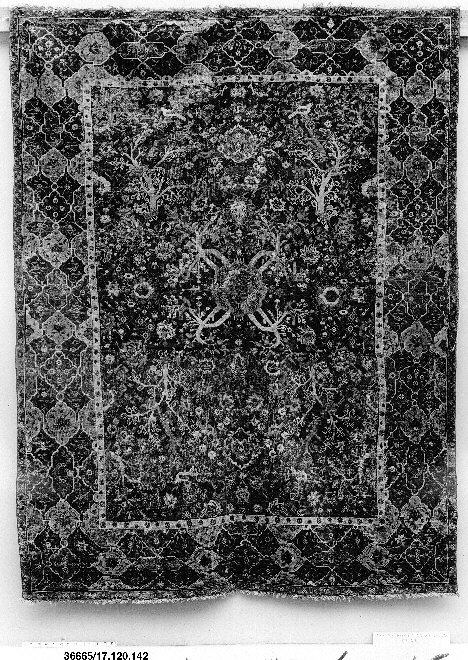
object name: carpet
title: Carpet with Tree and Bird Design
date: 1567-1600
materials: cotton, wool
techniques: asymmetrically knotted pile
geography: iran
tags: birds,trees